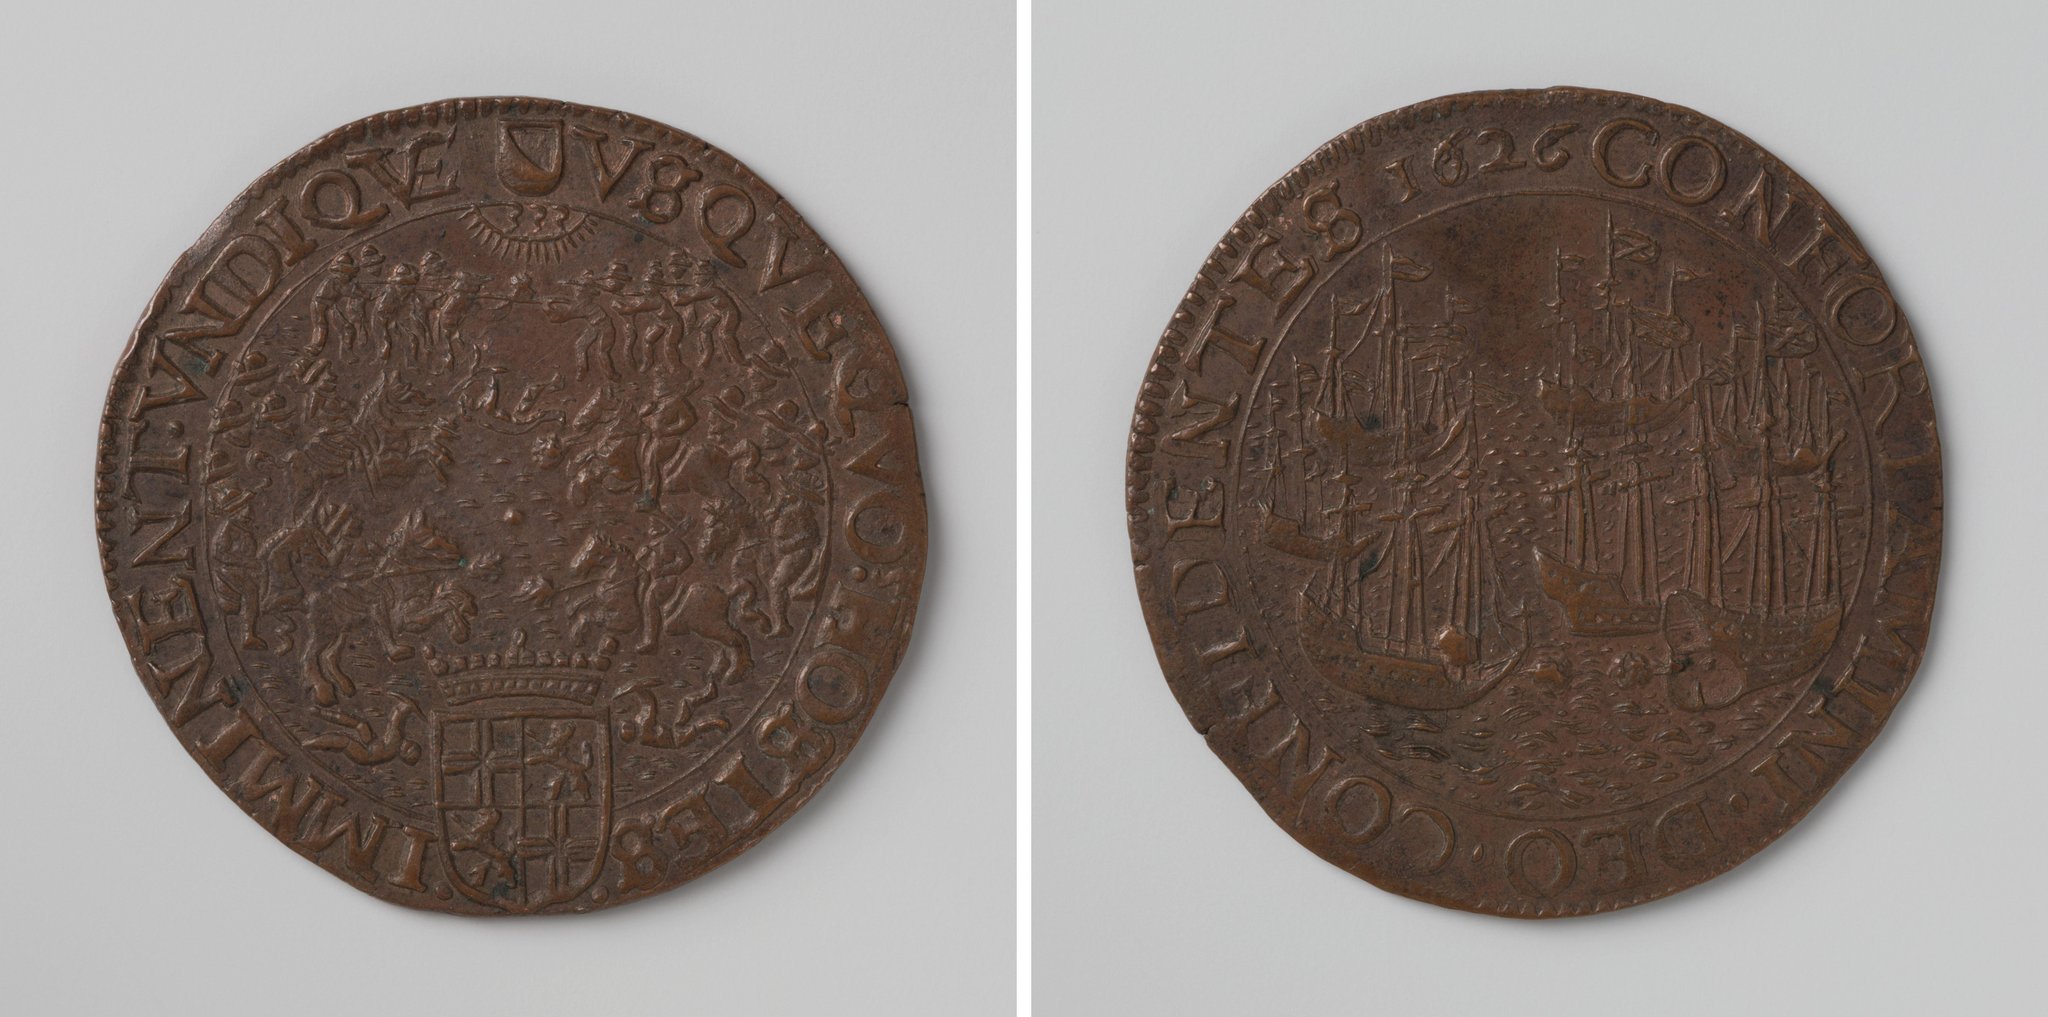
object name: jeton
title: Ongunstig verloop van de strijd tegen Spanje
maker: Anonymous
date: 1626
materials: copper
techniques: striking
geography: utrecht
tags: staten van utrecht, eemland, tachtigjarige oorlog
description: Koperen penning. Voorzijde: gevecht tussen ruiters en soldaten, beschenen door hemellicht met daarin naam jehovah in hebreeuws schrift boven wapenschild binnen omschrift. Keerzijde: schepen op zee met elkaar in gevecht binnen omschrift.